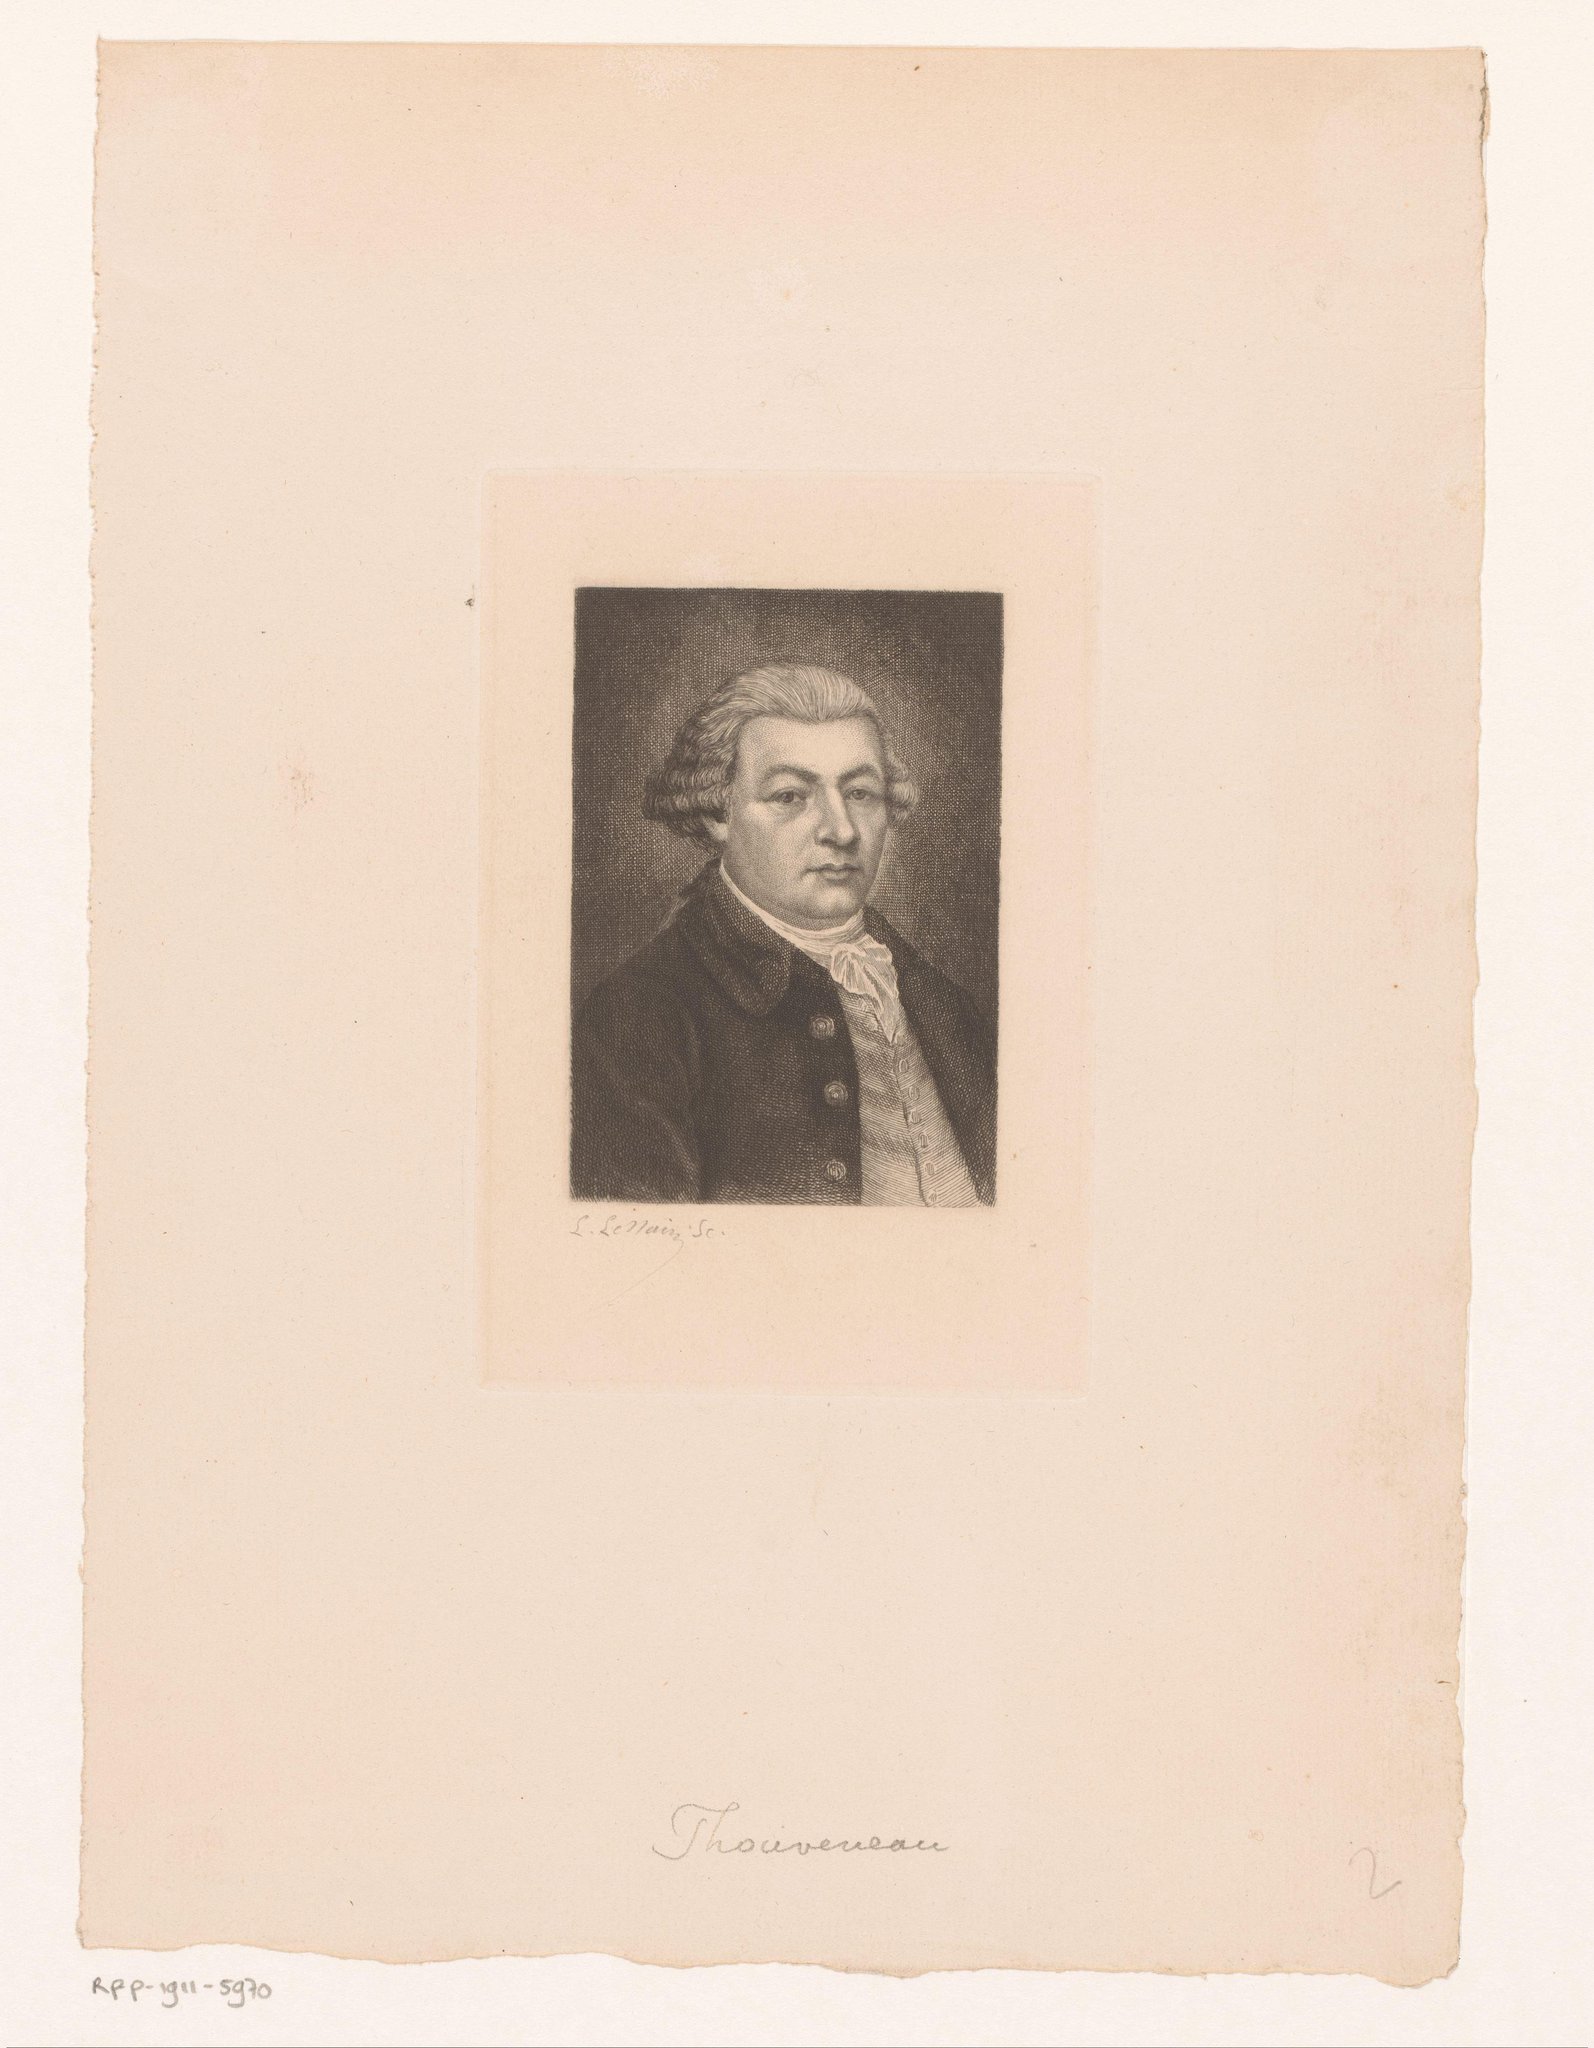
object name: print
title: Portret van Charles Théveneau de Morande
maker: louis le nain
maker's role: print maker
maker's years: 1851-1939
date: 1861-1911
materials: paper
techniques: etching, intaglio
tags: adult man, historical persons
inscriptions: collector's mark: Lugt 2228